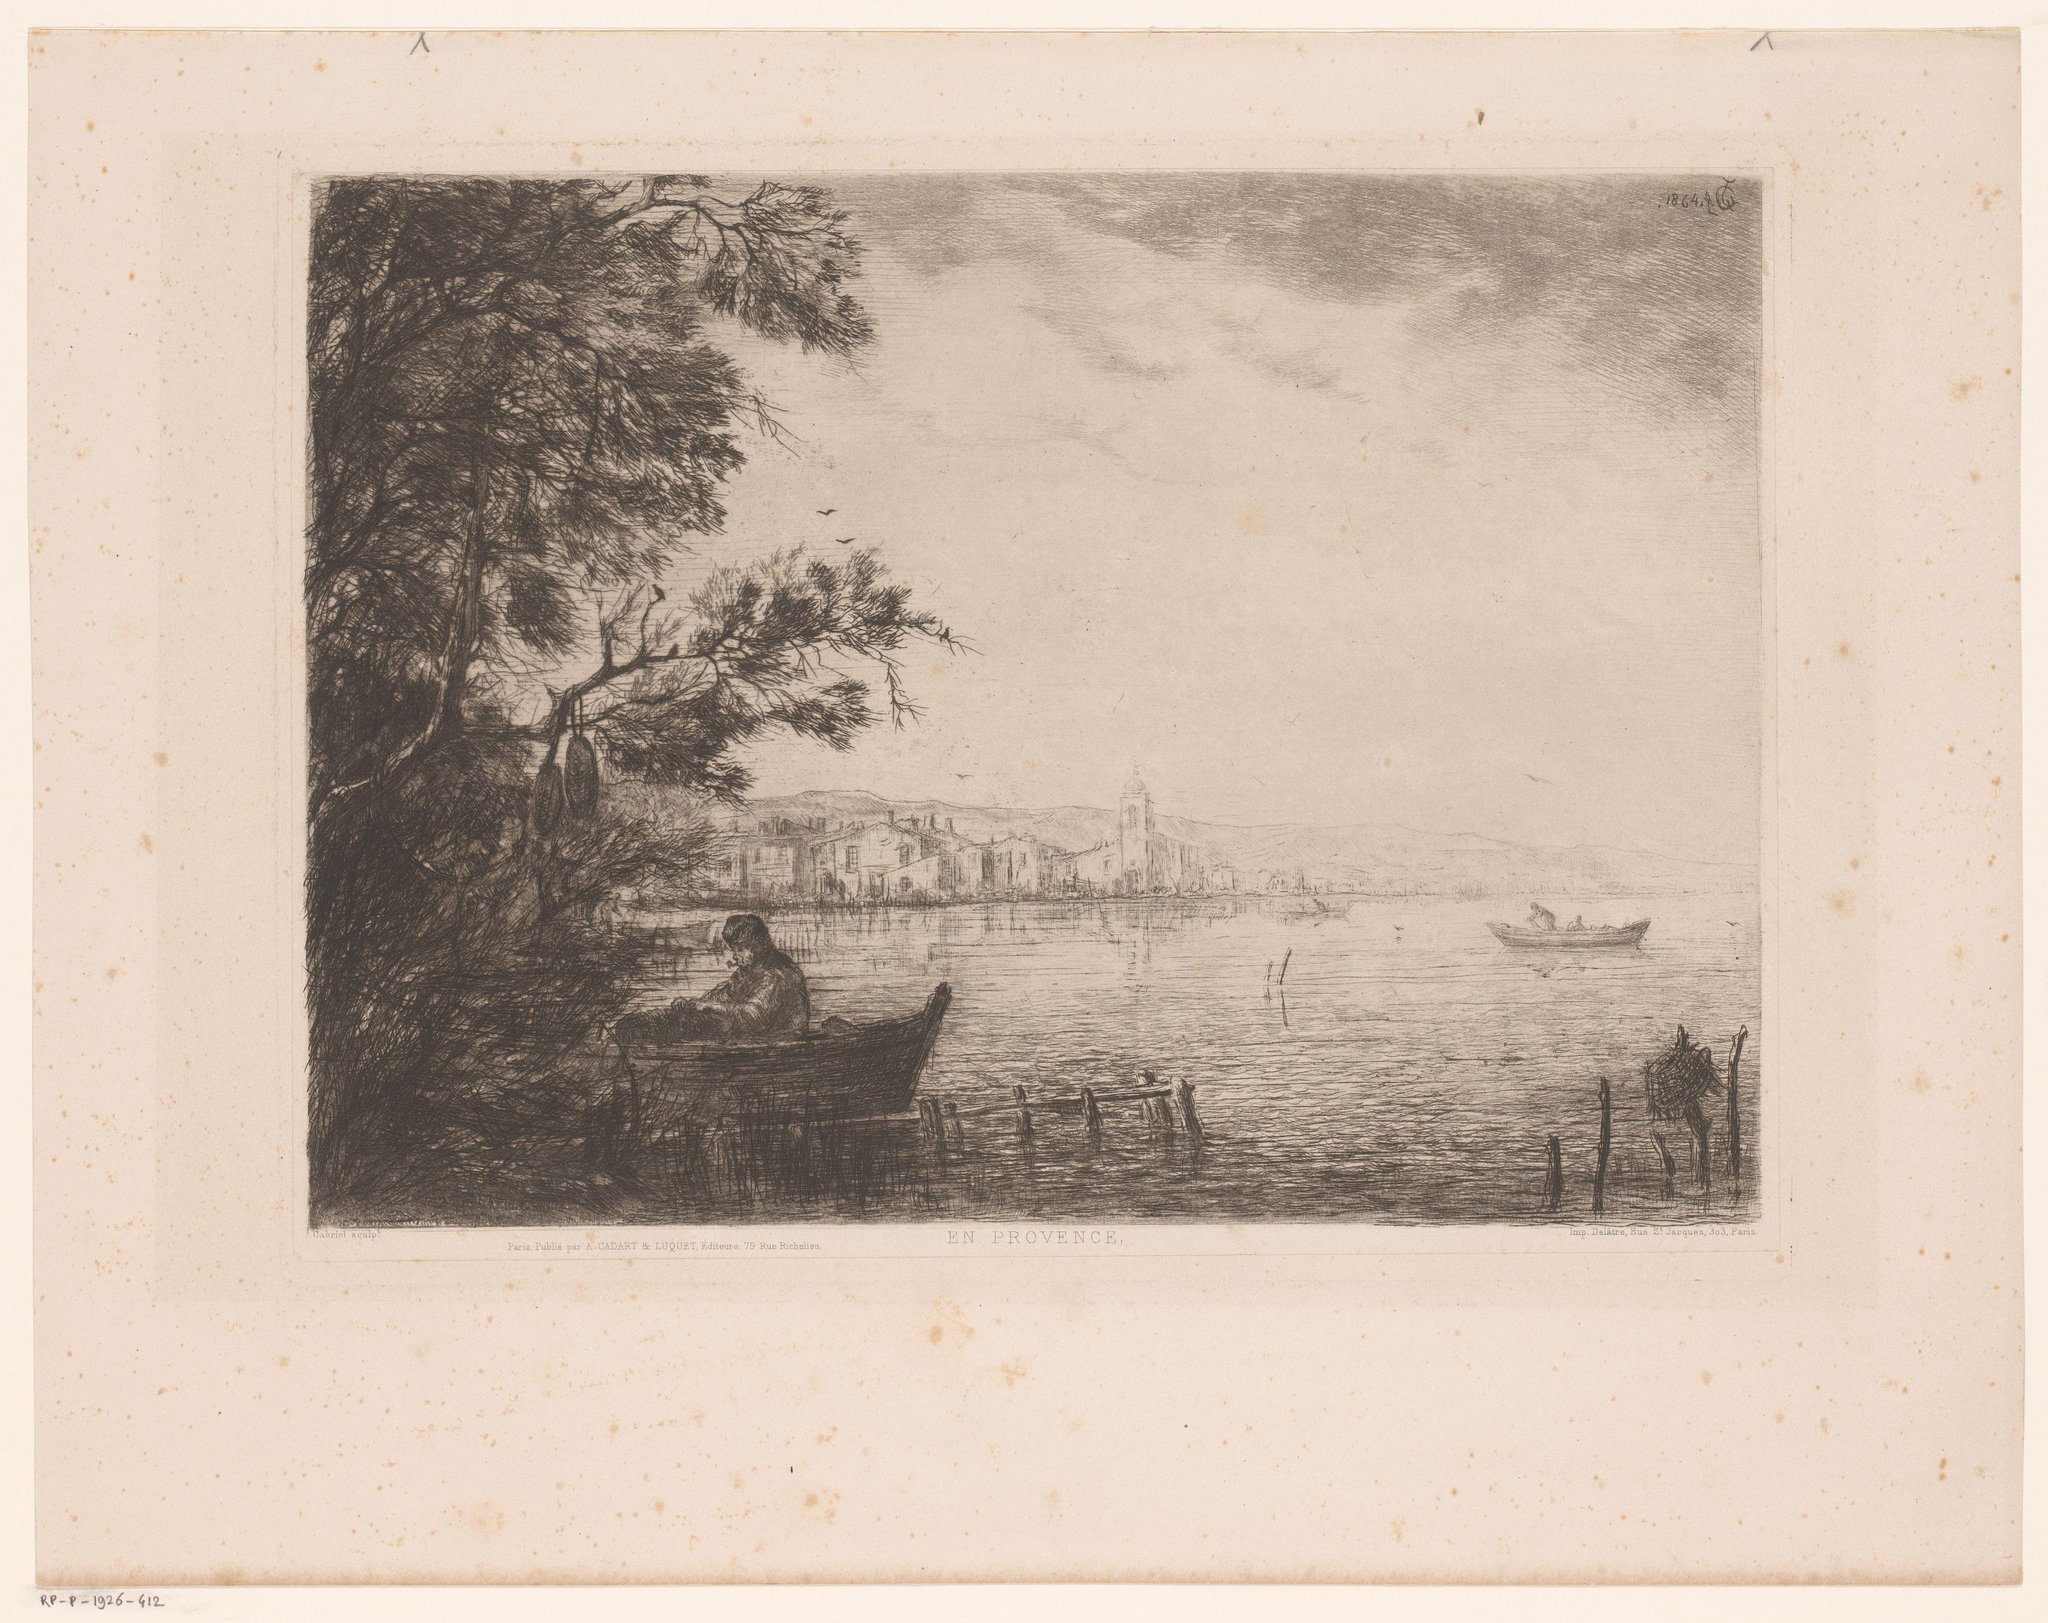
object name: print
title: Gezicht op een dorp aan een meer met links een visser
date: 1864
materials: paper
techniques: drypoint, etching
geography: paris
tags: prospect of city, town panorama, silhouette of city, fisherman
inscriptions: collector's mark: Lugt 2166